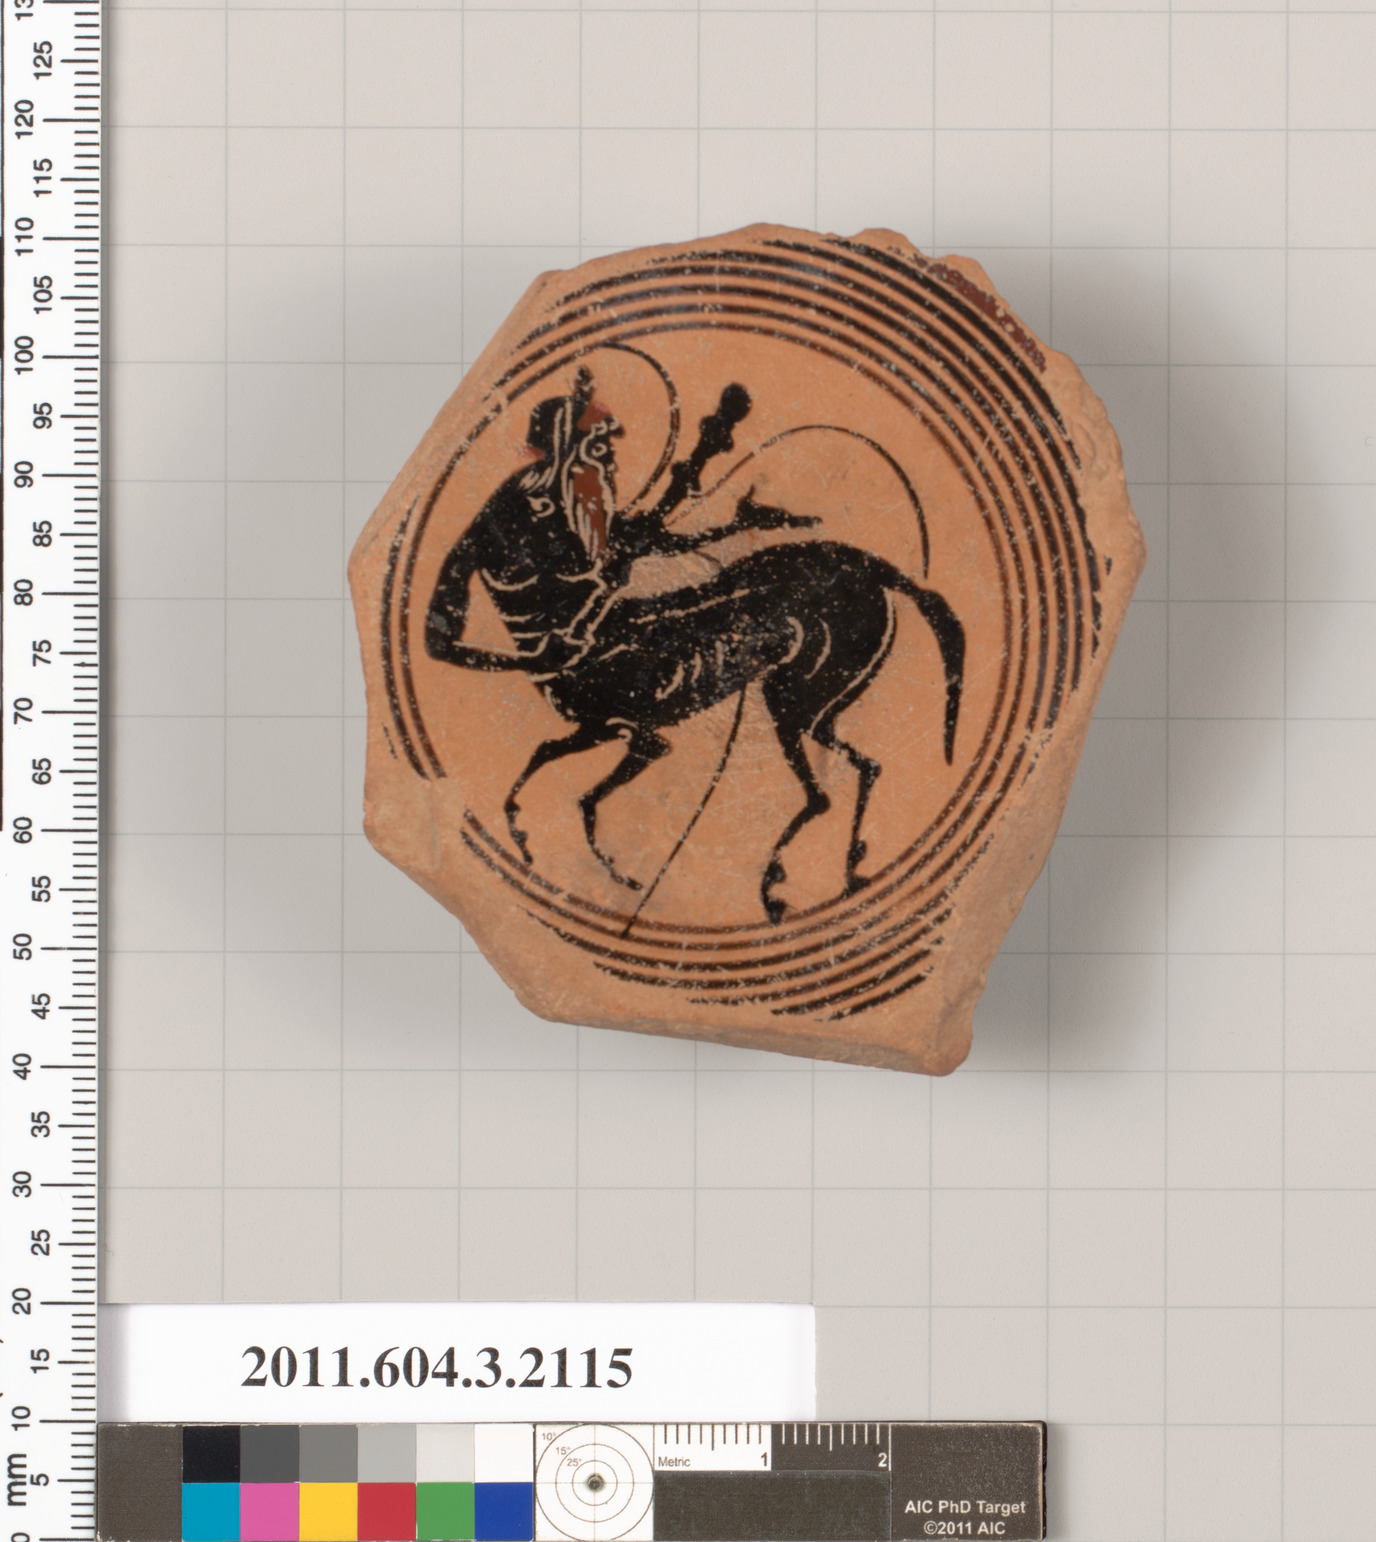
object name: kylix fragment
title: Terracotta fragment of a kylix (drinking cup)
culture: greek, attic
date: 534-468 BCE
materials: terracotta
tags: centaurs